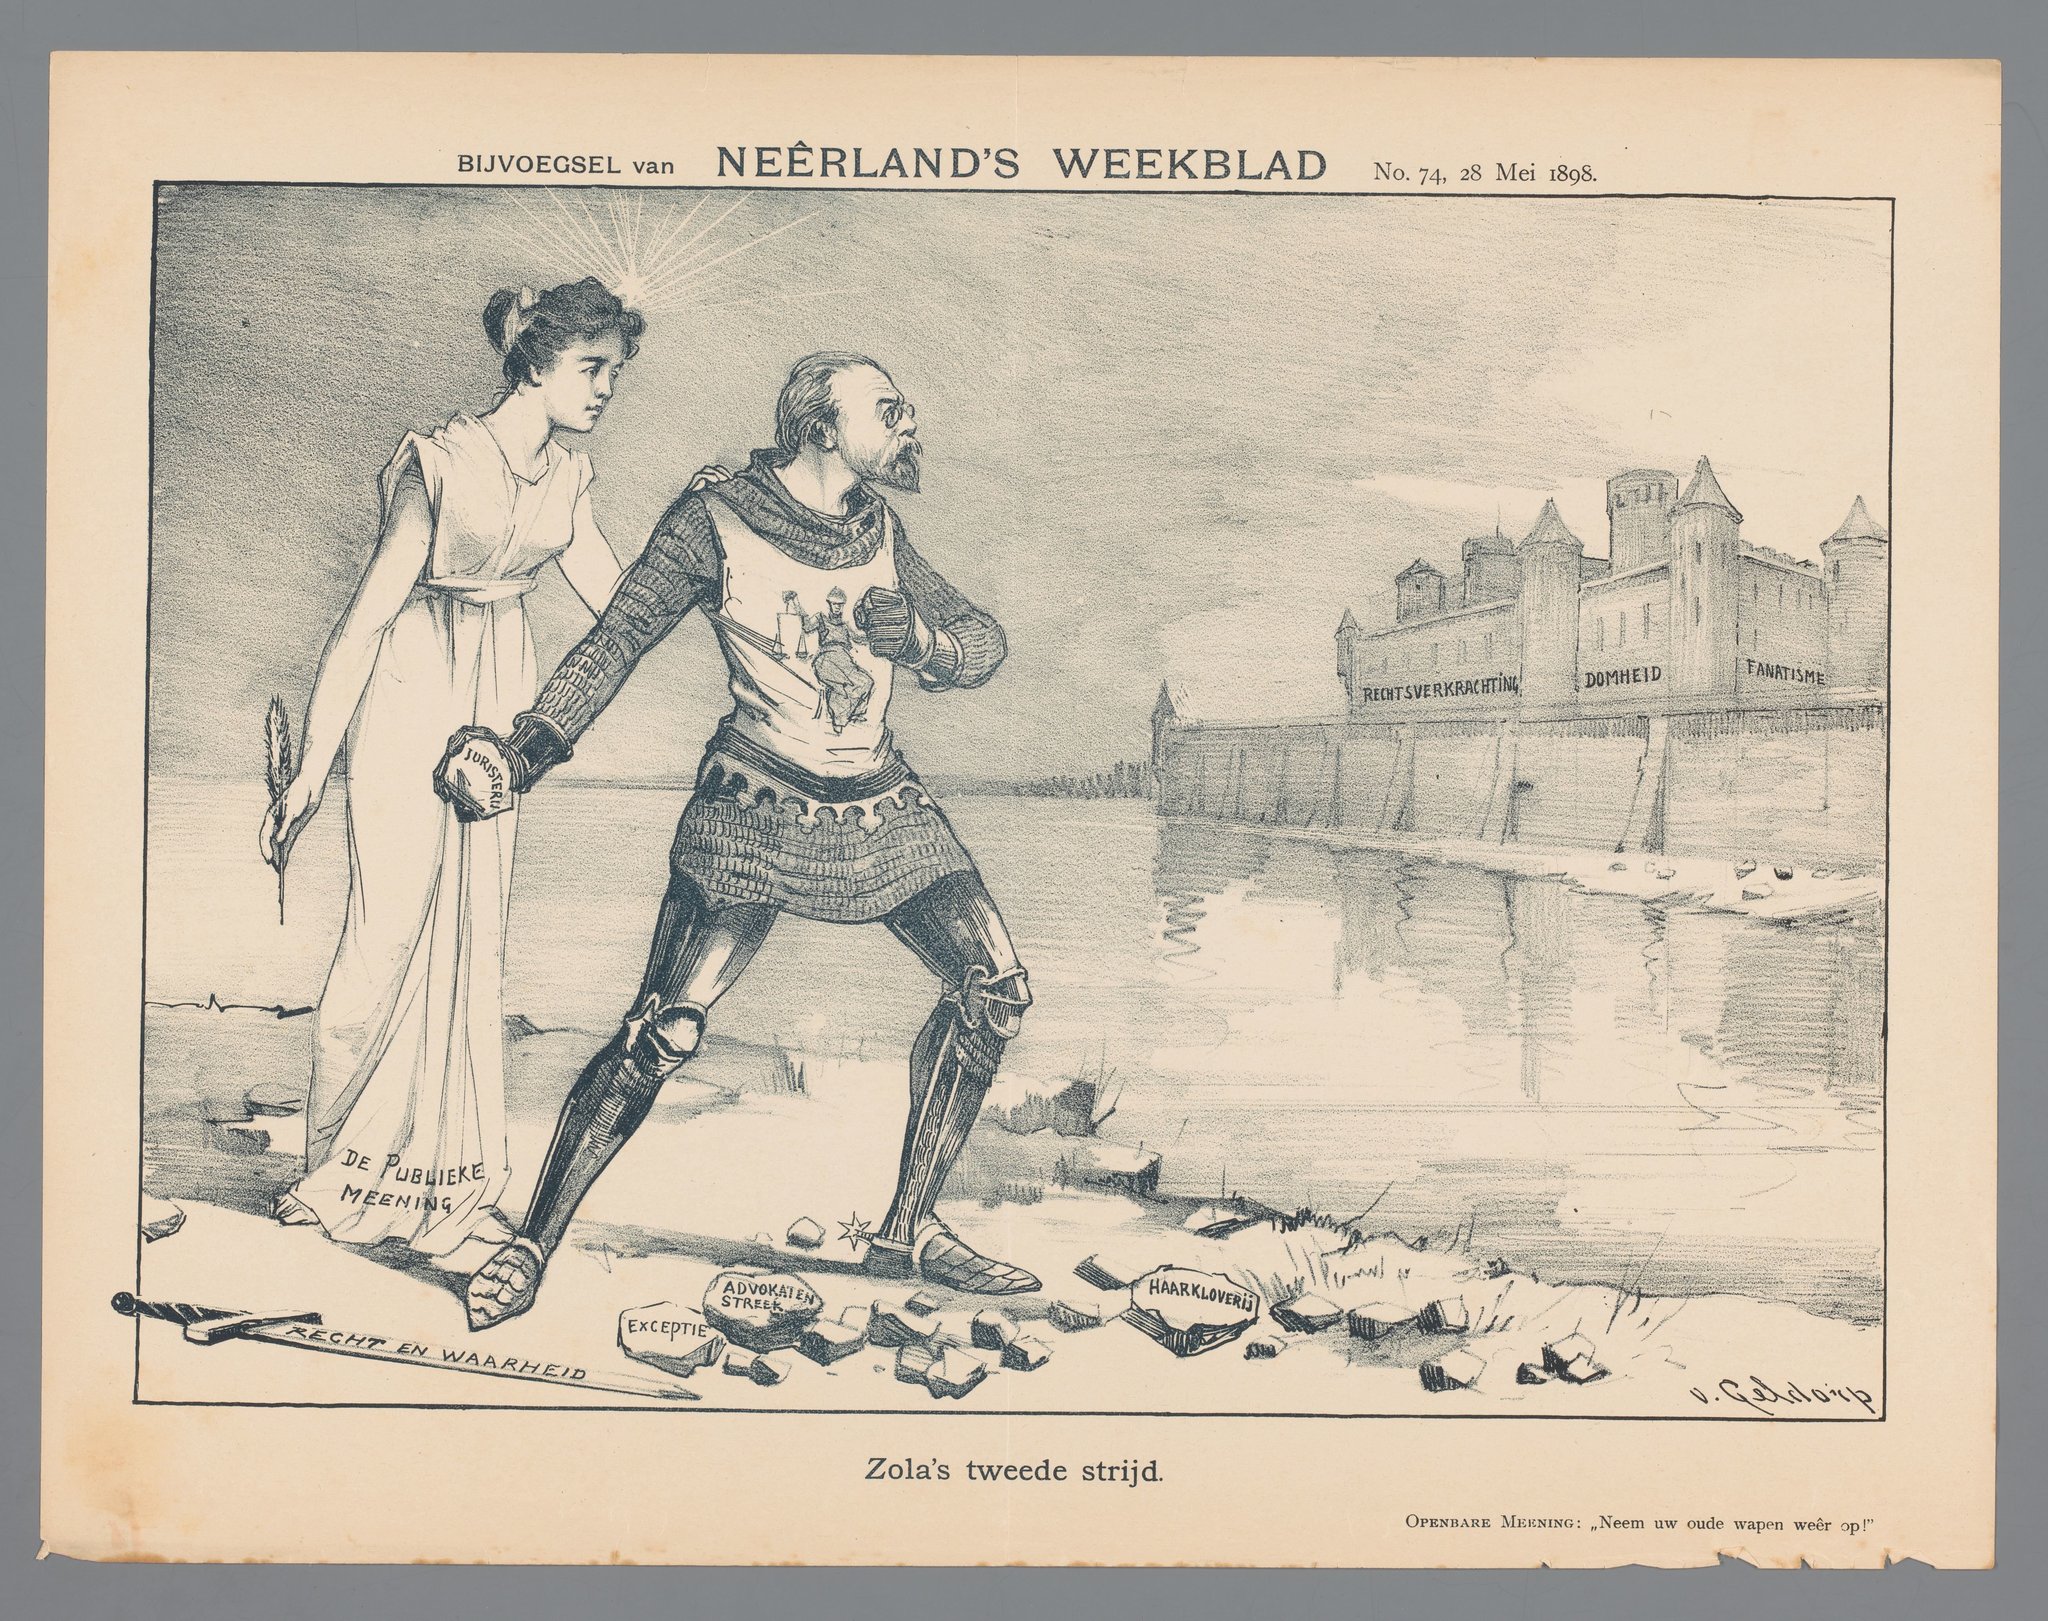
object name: cartoon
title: Zola's tweede strijd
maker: petrus van geldorp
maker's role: draughtsman, print maker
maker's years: 1872-1939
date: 1898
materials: paper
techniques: lithograph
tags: paris, emile zola, knight, political caricatures and satires, france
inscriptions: date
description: Prent uit het bijvoegsel van: Neêrland’s Weekblad, nr. 74, 28 mei 1898.